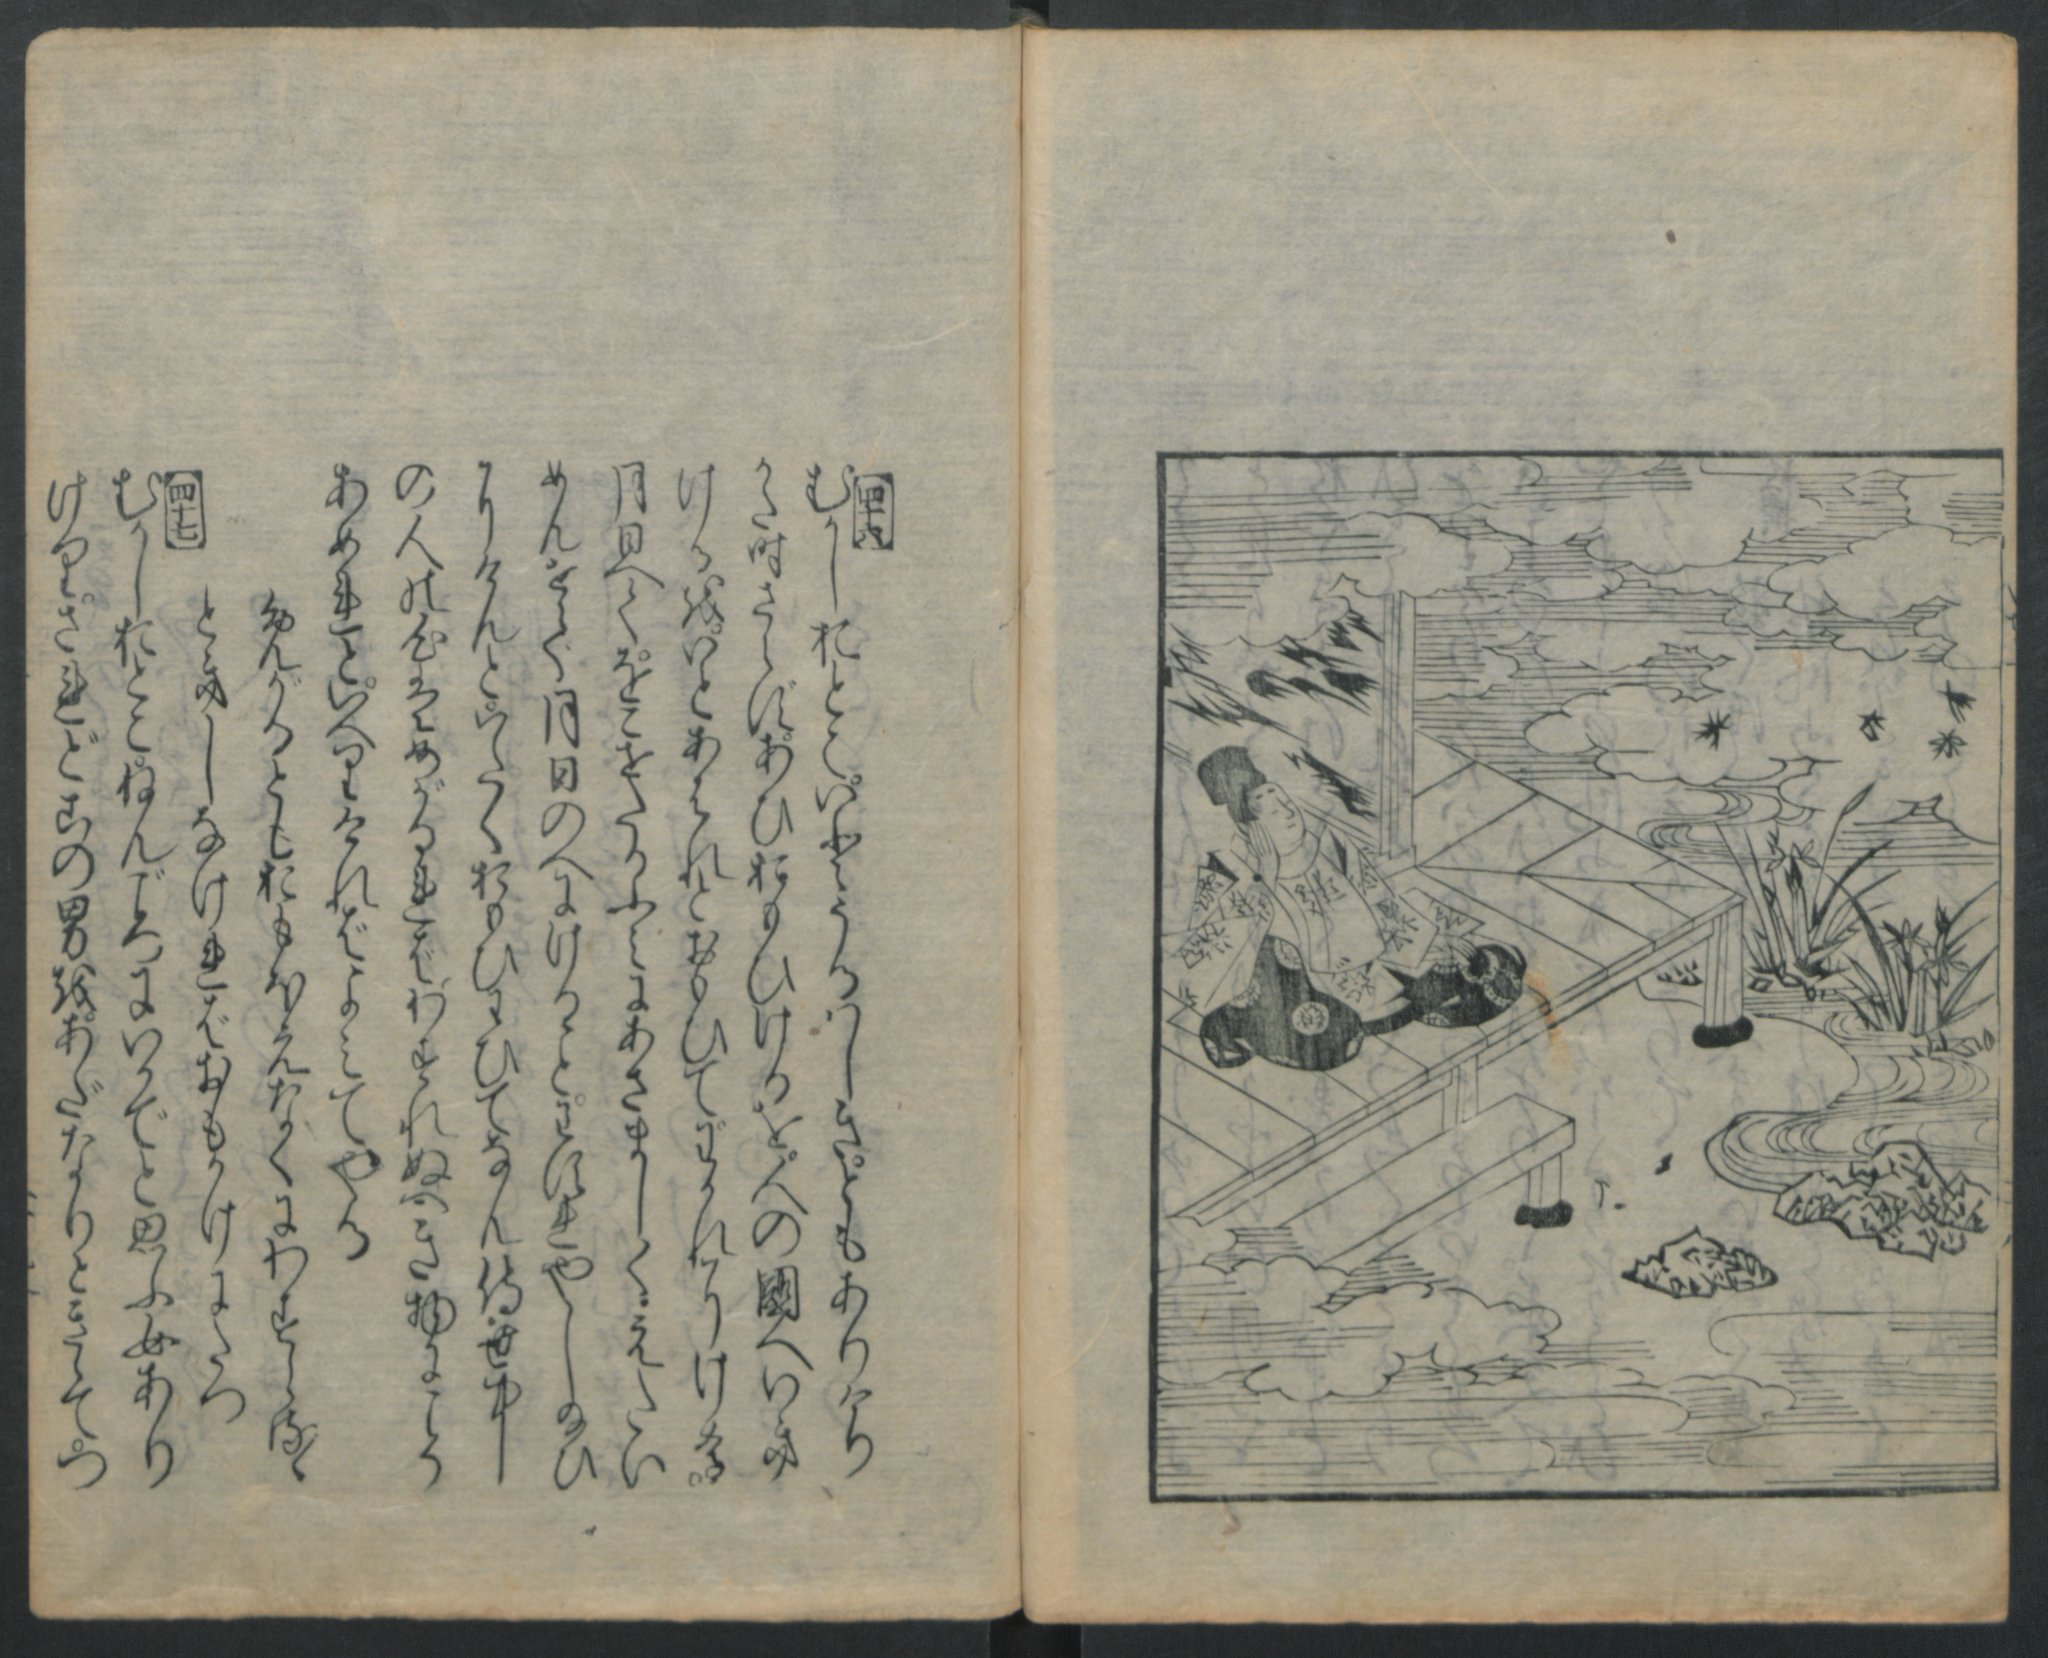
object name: illustrated book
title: Saga Edition of “The Tales of Ise” [Ise Monogatari) 伊勢物語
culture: japanese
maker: unidentified artist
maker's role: artist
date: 1608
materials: ink, paper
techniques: woodblock print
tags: women,deer